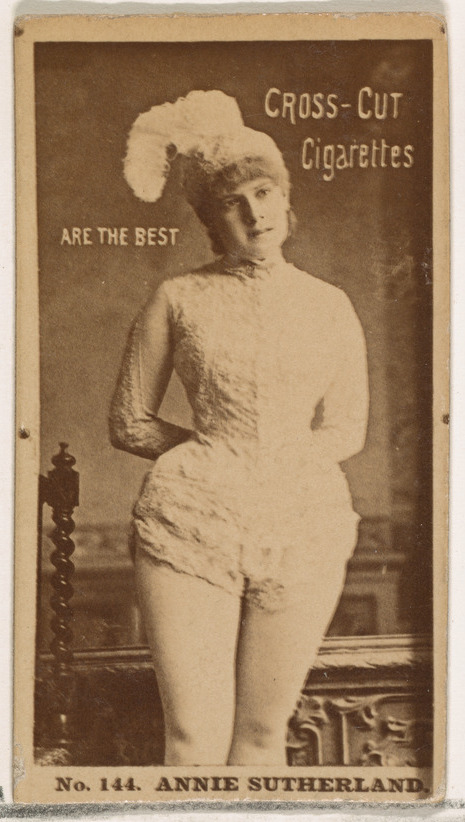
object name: print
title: Card Number 144, Annie Sutherland, from the Actors and Actresses series (N145-2) issued by Duke Sons & Co. to promote Cross Cut Cigarettes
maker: w. duke, sons & co.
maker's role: publisher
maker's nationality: american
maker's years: 1870-1920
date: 1880-1889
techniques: albumen silver print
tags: portraits,women,actresses